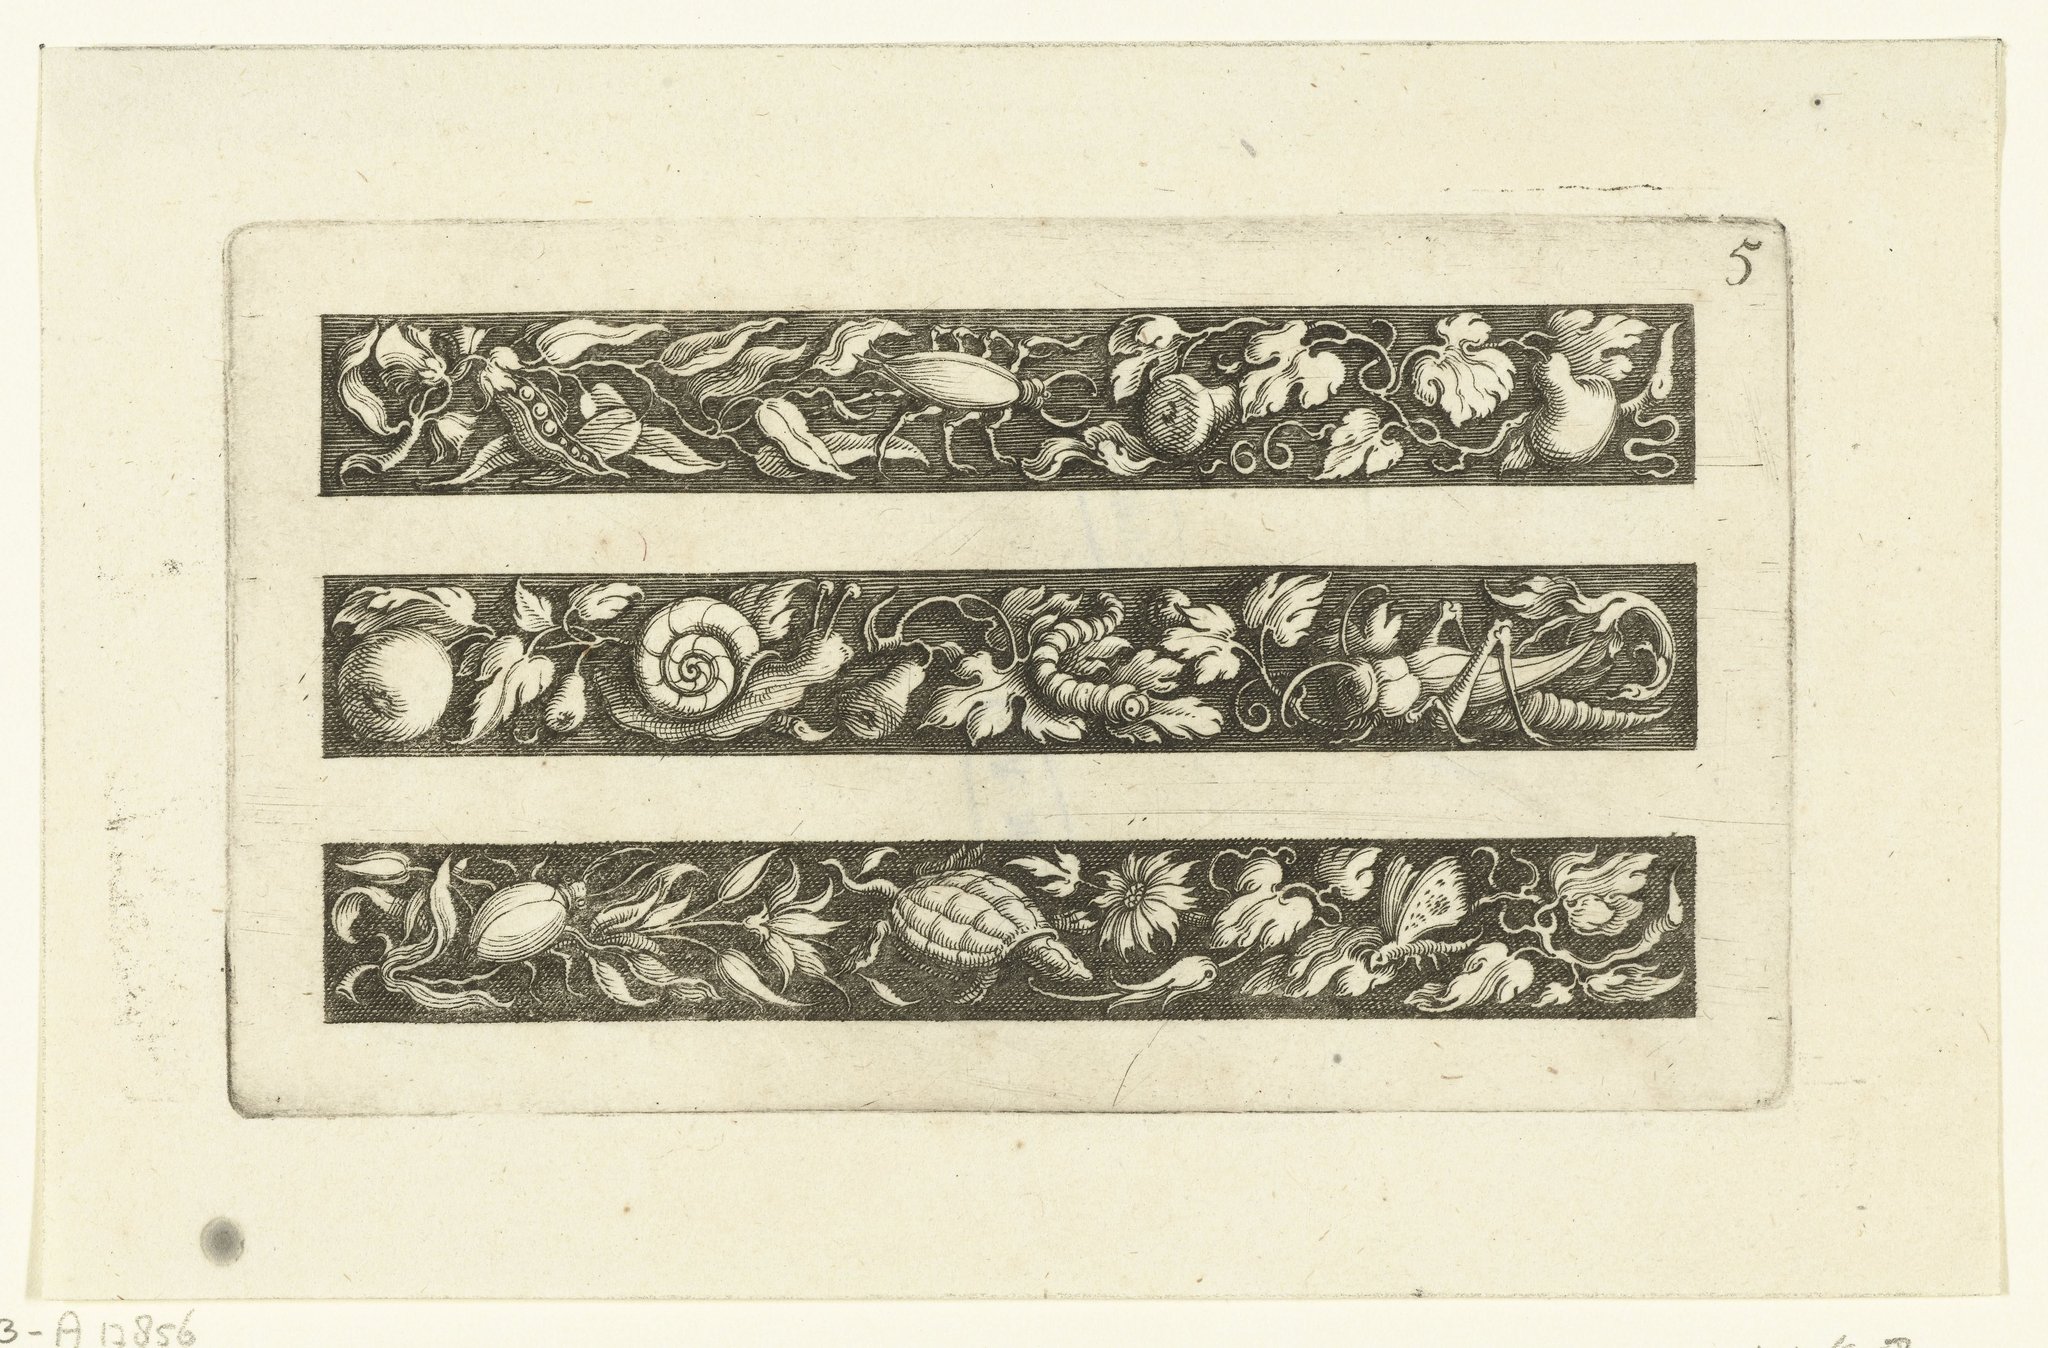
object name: ornament print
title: Friezen met dieren, insecten en vogels tussen bladranken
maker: michiel le blon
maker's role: print maker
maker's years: 1587-1656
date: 1611-1625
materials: paper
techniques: engraving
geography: amsterdam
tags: foliage ~ ornament, fruits and vegetables ~ ornament, insects